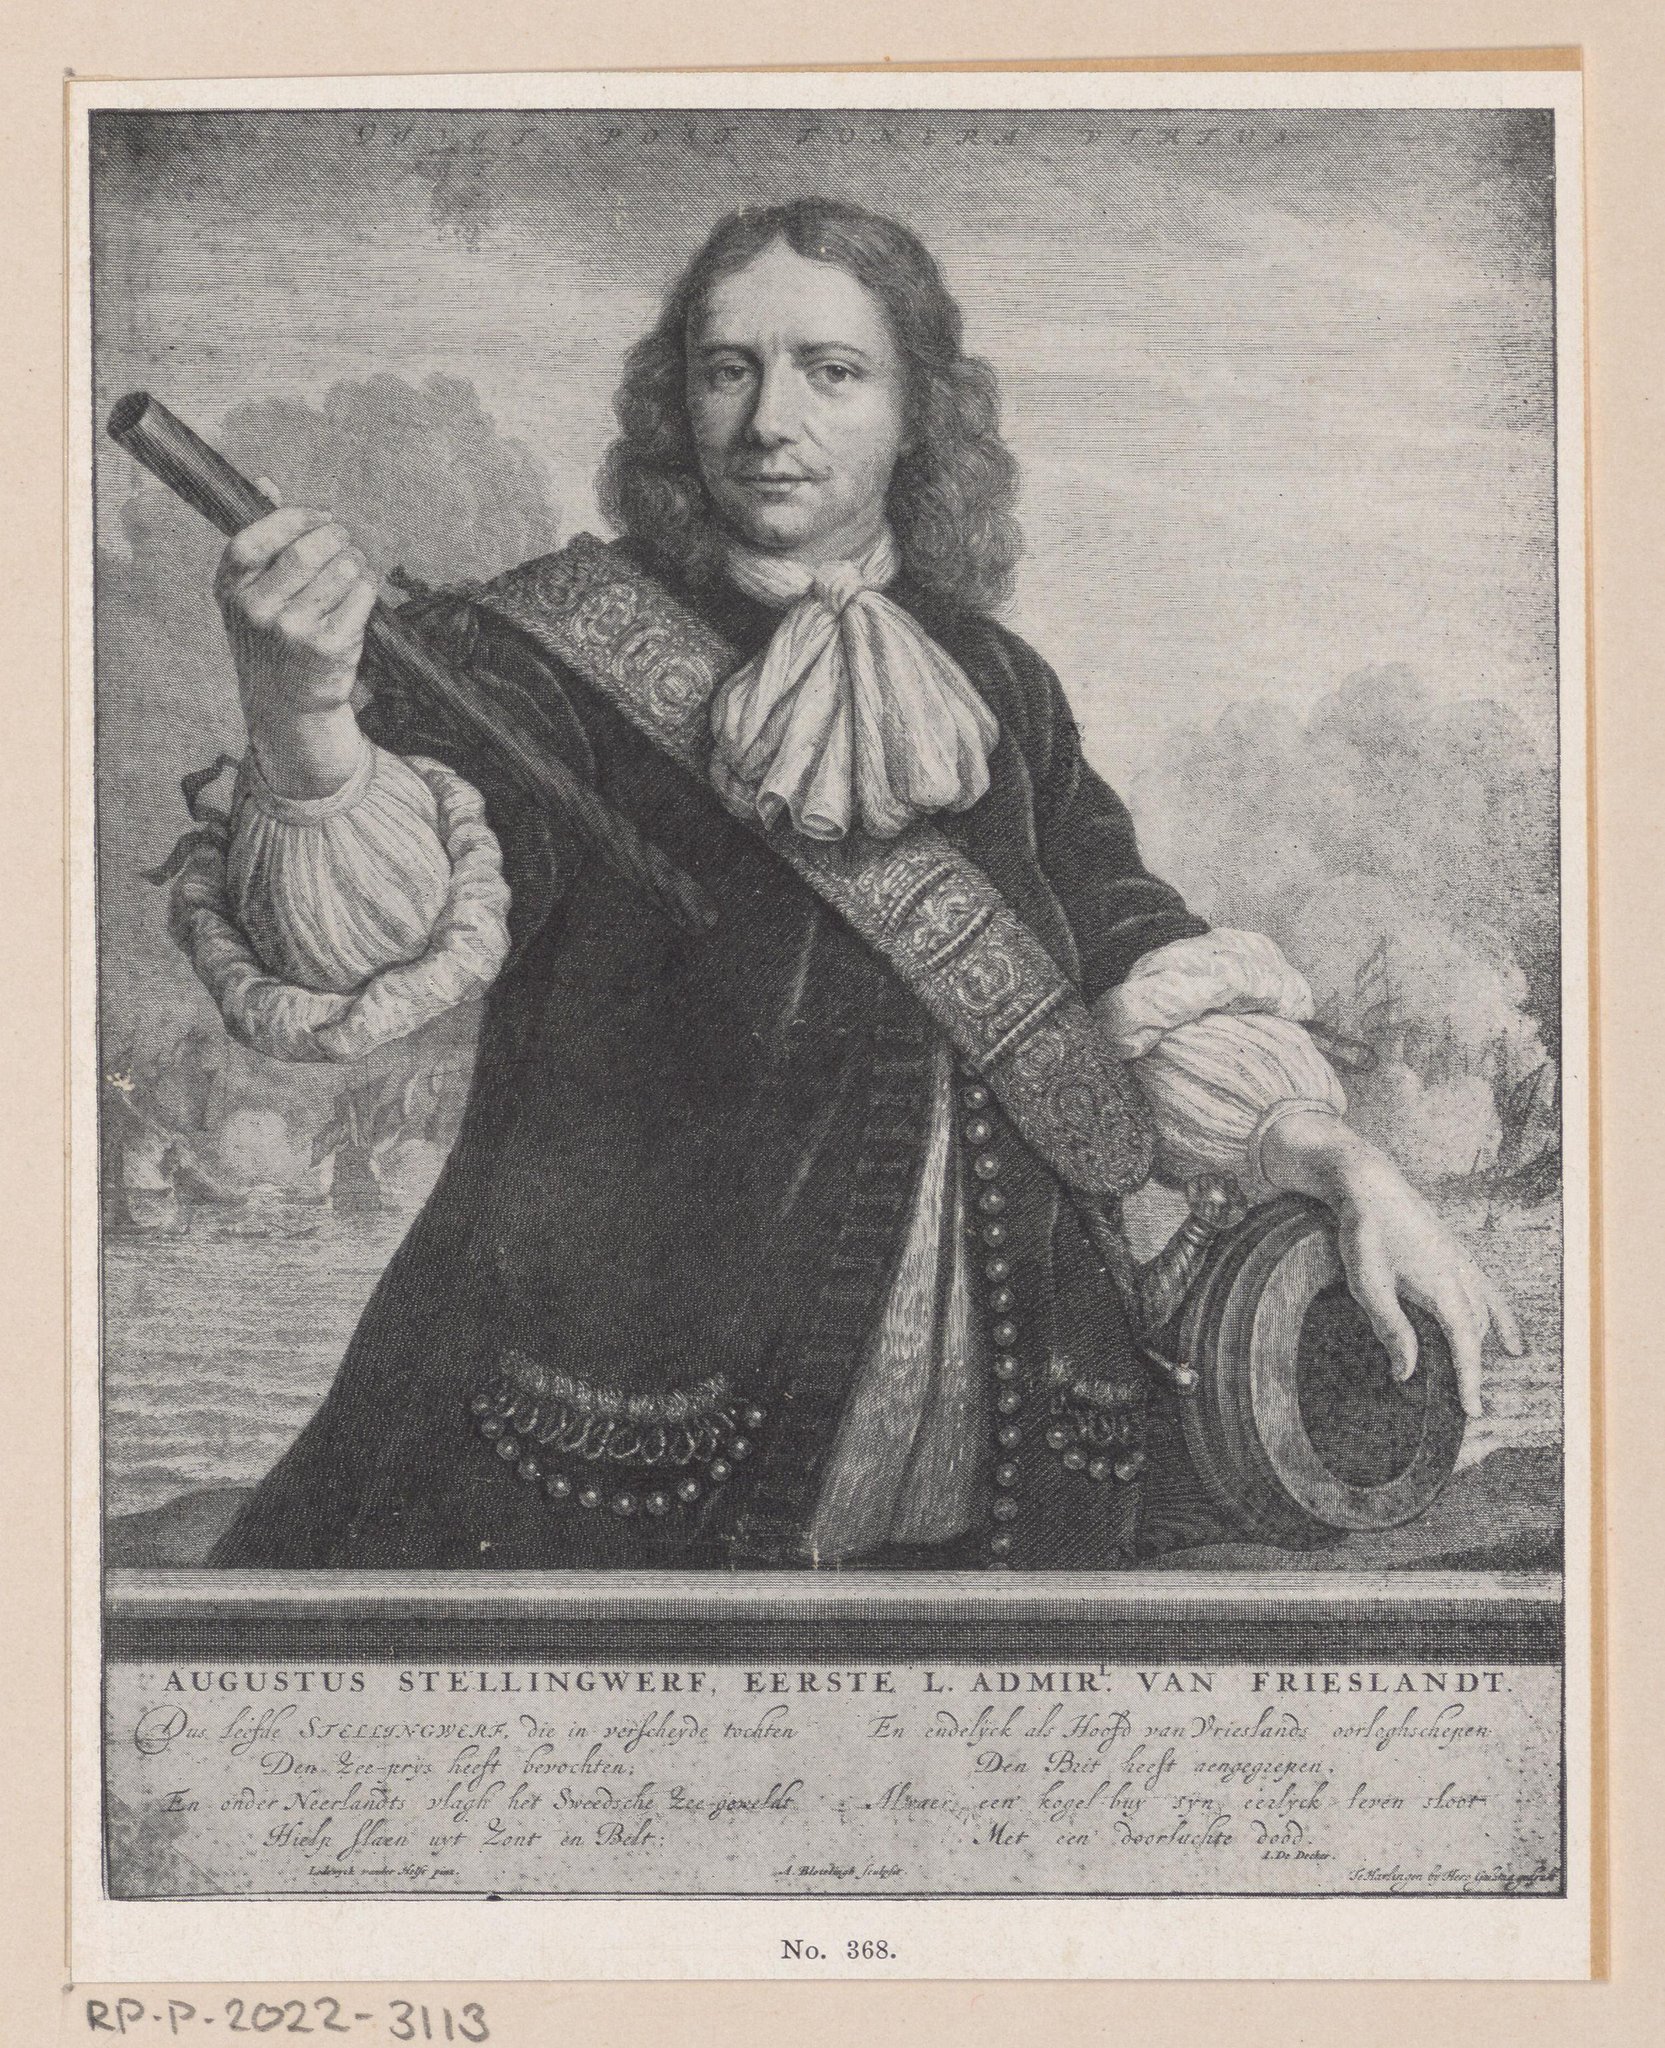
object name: photomechanical print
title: Portret van Aucke Stellingwerff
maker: Anonymous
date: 1882-1970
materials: paper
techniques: autotype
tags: historical persons, commander-in-chief, admiral